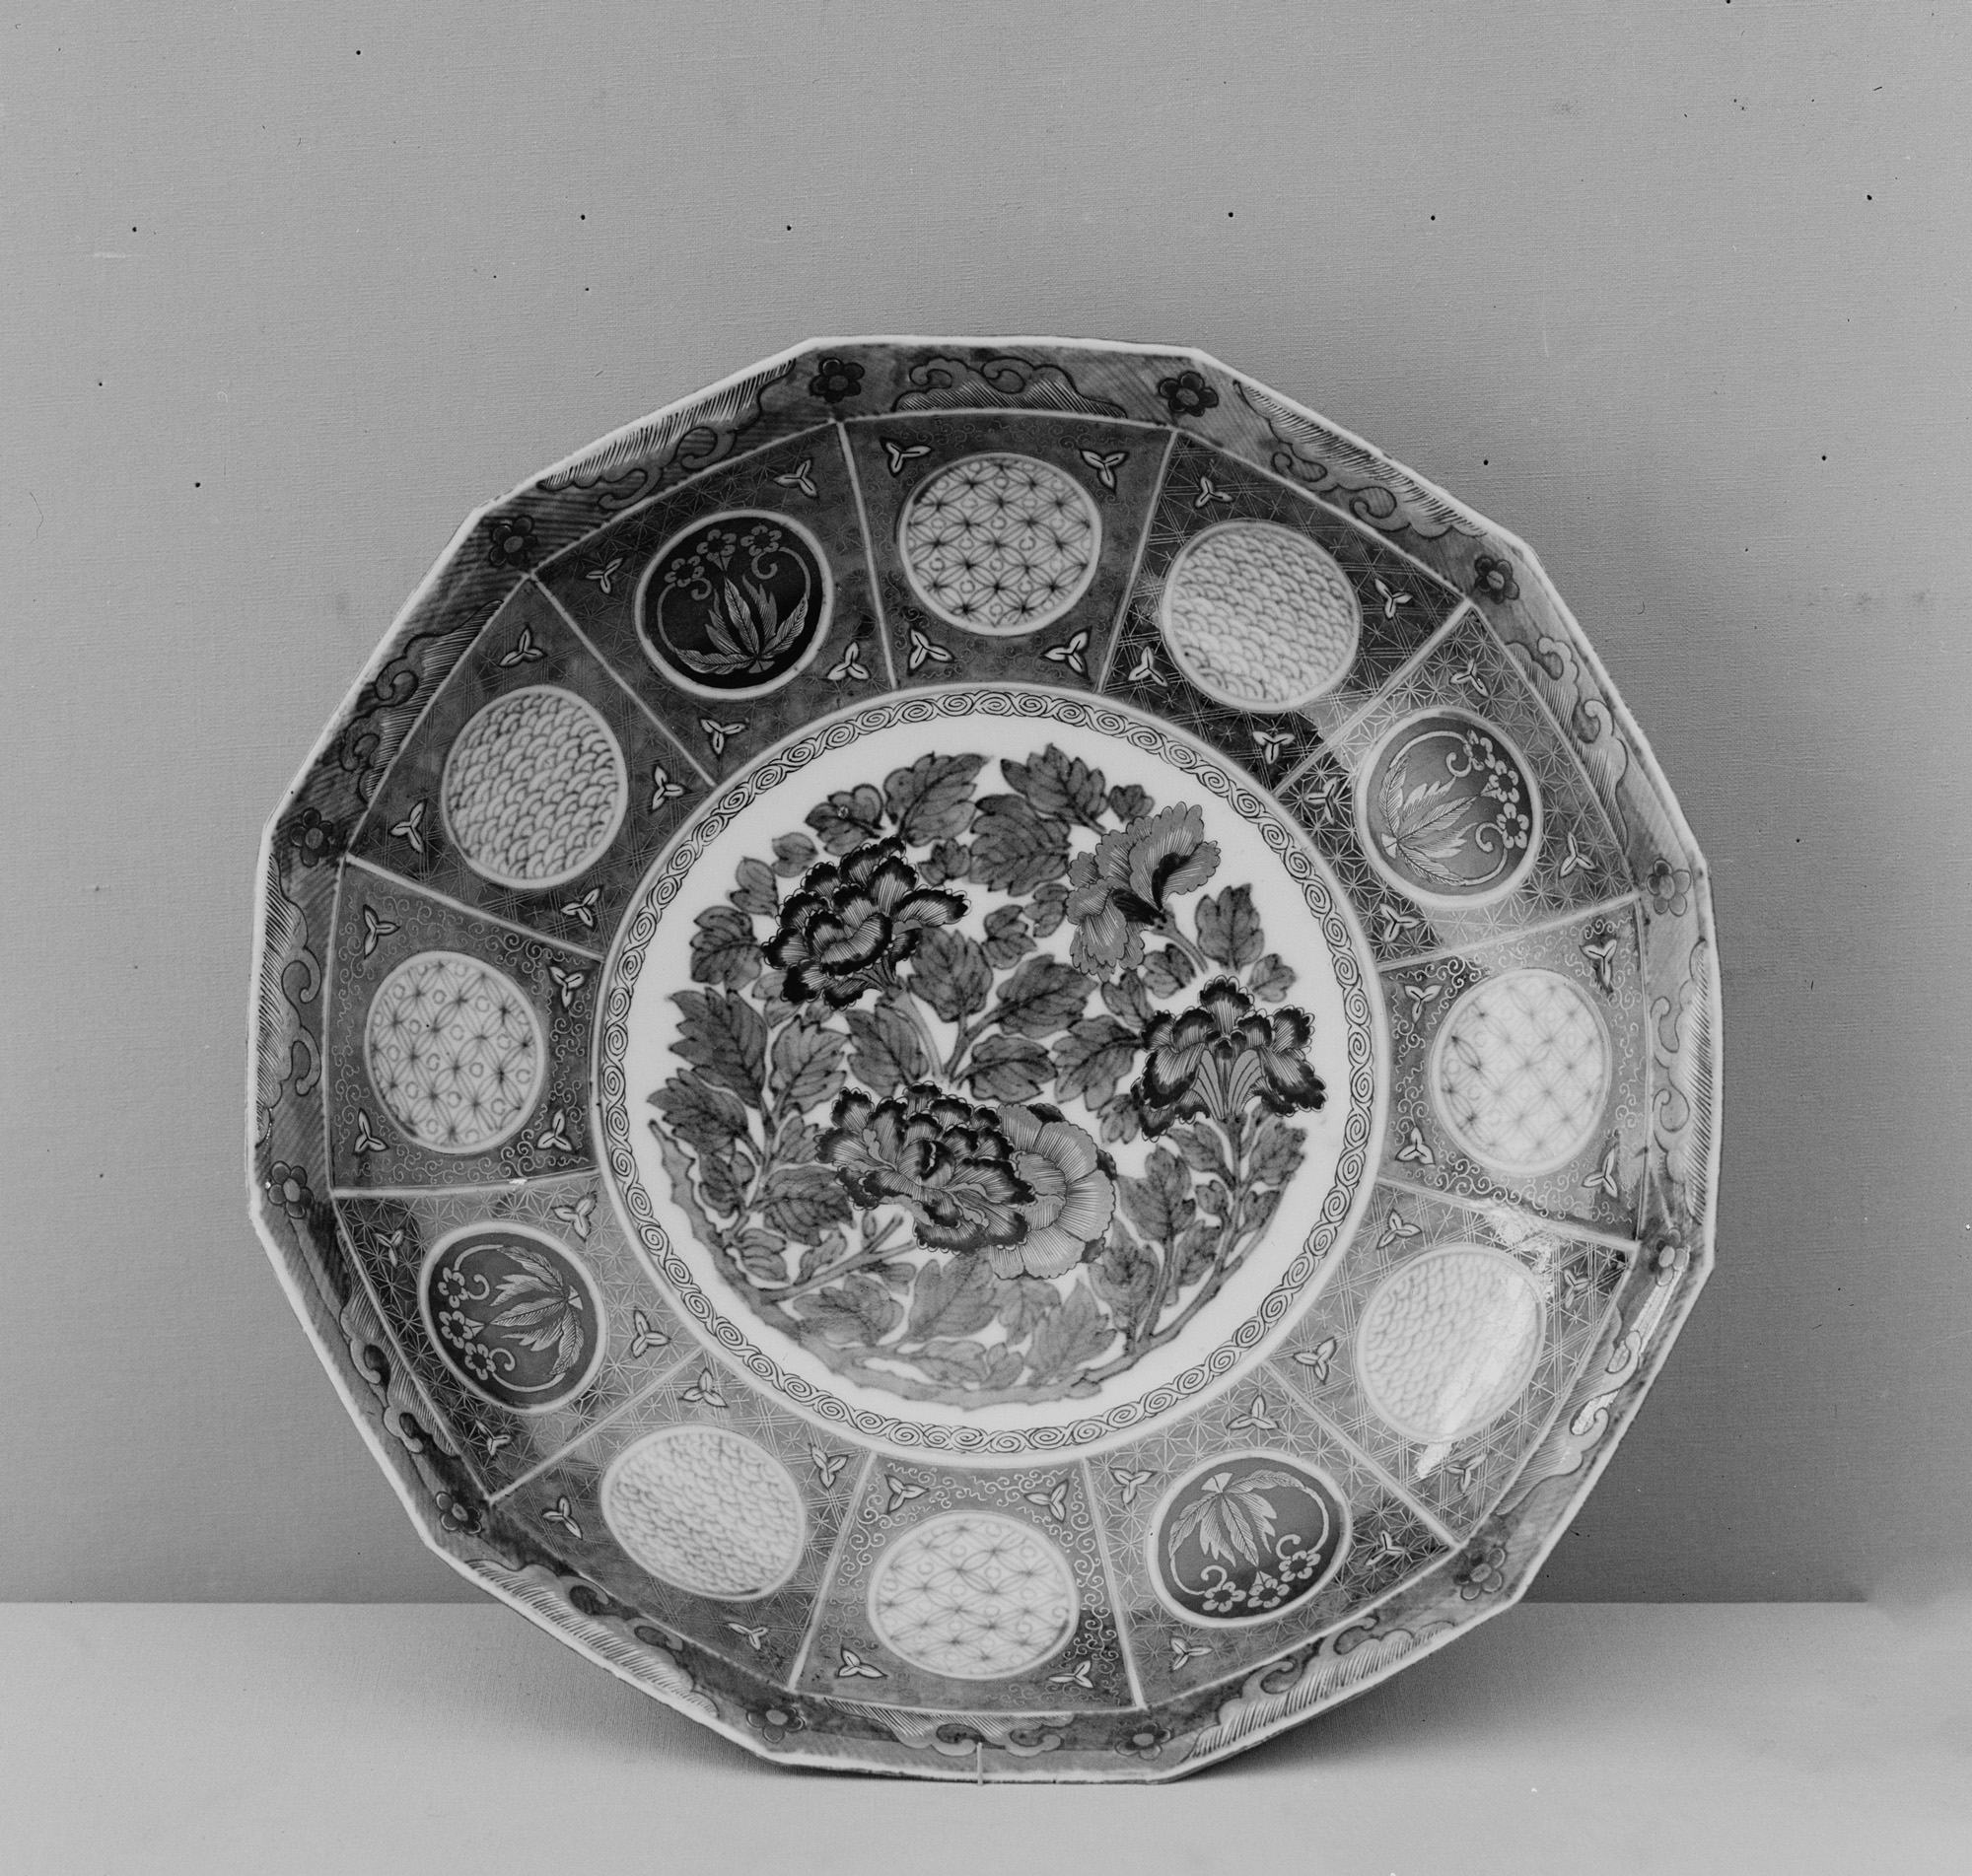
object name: dish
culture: japanese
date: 1750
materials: glaze, gold, iron, porcelain